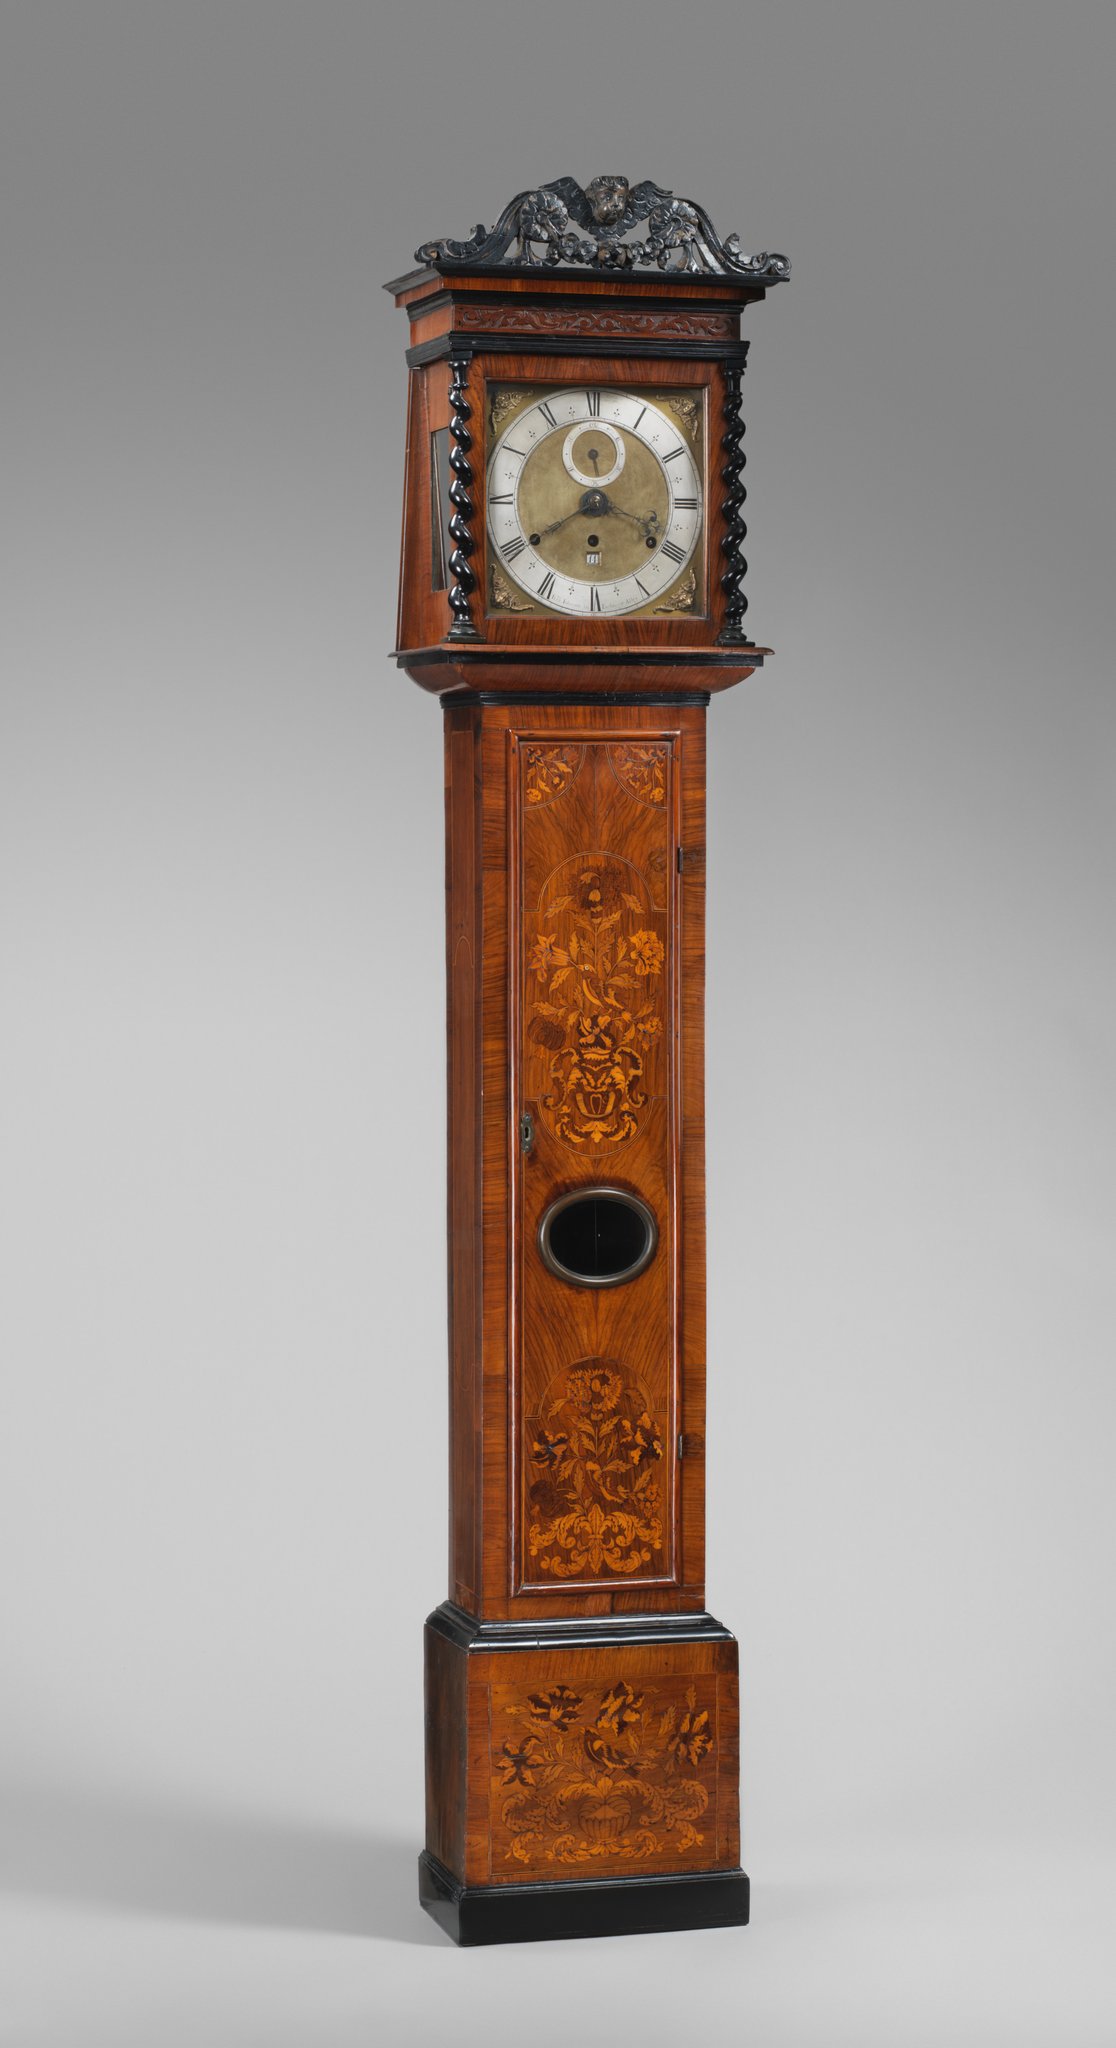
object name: longcase clock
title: Longcase clock with calendar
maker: jeremiah johnson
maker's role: maker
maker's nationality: british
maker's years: 1646-1709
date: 1685-1690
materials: brass, wood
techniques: gilding, silvered, veneering